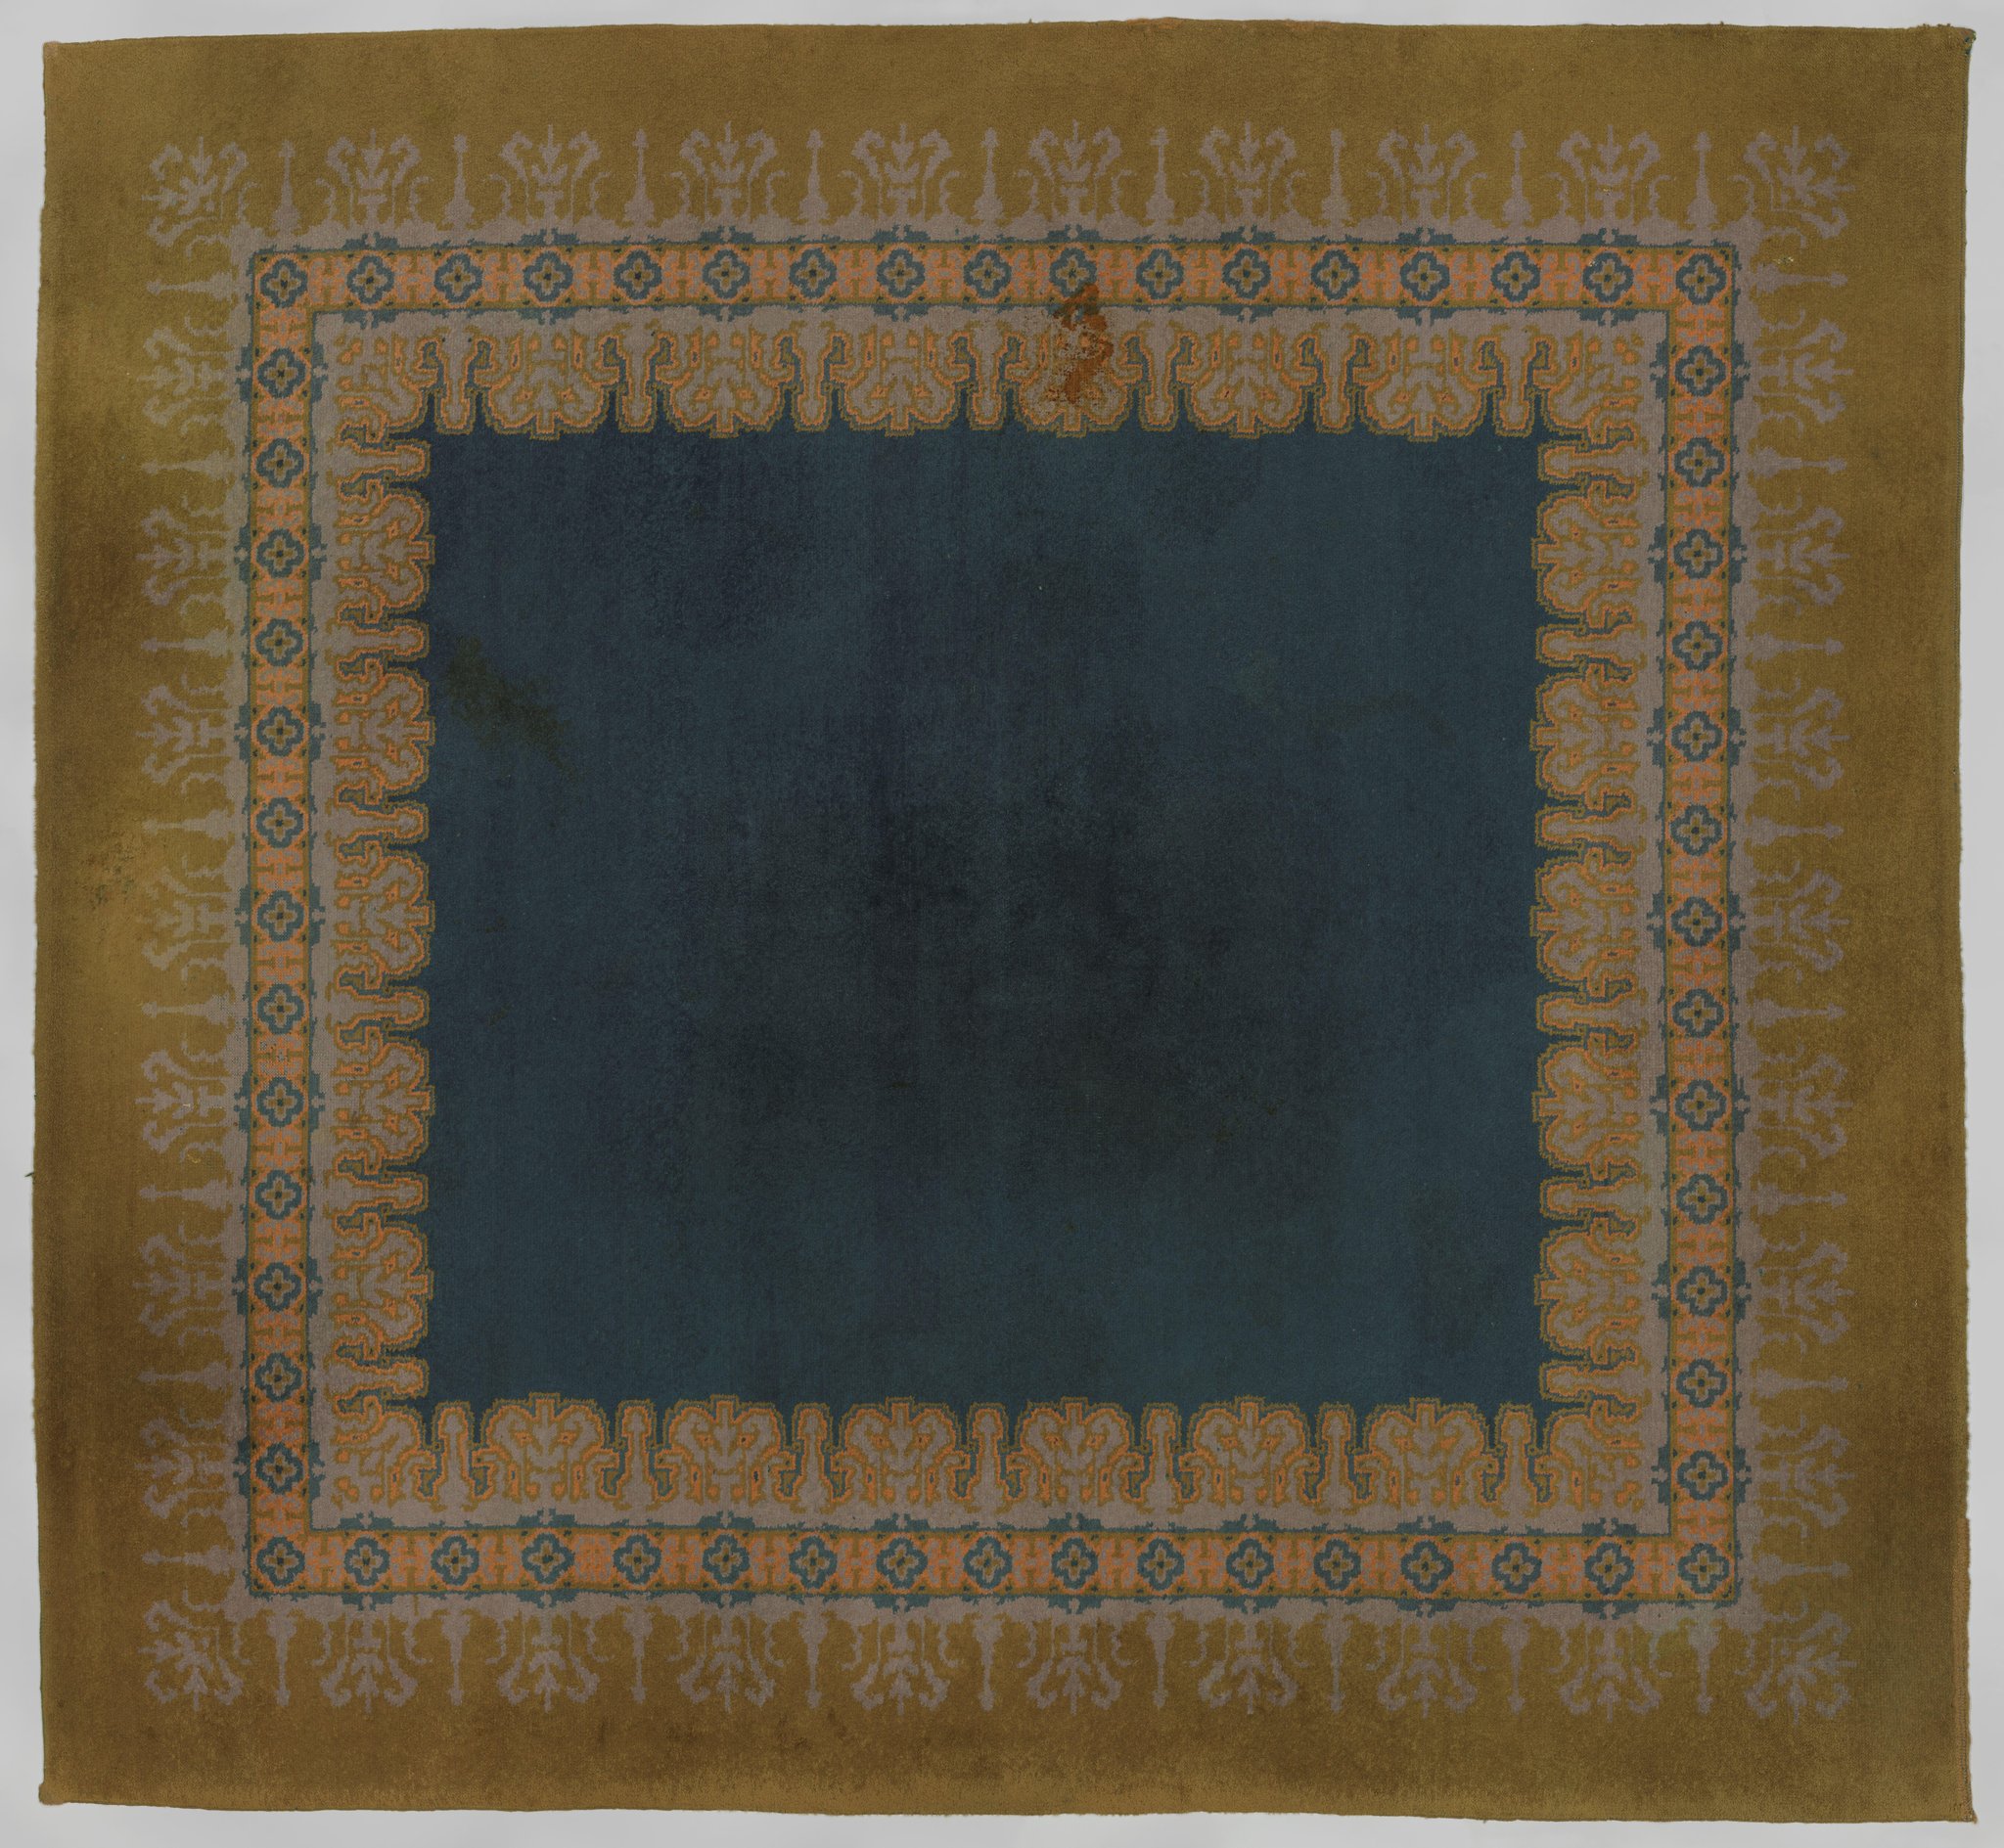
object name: carpet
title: Geknoopt vloerkleed, met blauw middenstuk en ornamentrand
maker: theo colenbrander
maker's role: draughtsman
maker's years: 1841-1930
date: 1925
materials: cotton, wool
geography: netherlands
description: Geknoopt vloerkleed, met blauw middenstuk en ornamnetrand in grijs, groen, blauw en geeloranje en effen groene buitenrand. Ontwerp van Th.A.C. Colenbrander (1841-1930). Op een aantal plaatsen zitten slijtageplekken en enkele kleine motgaatjes.